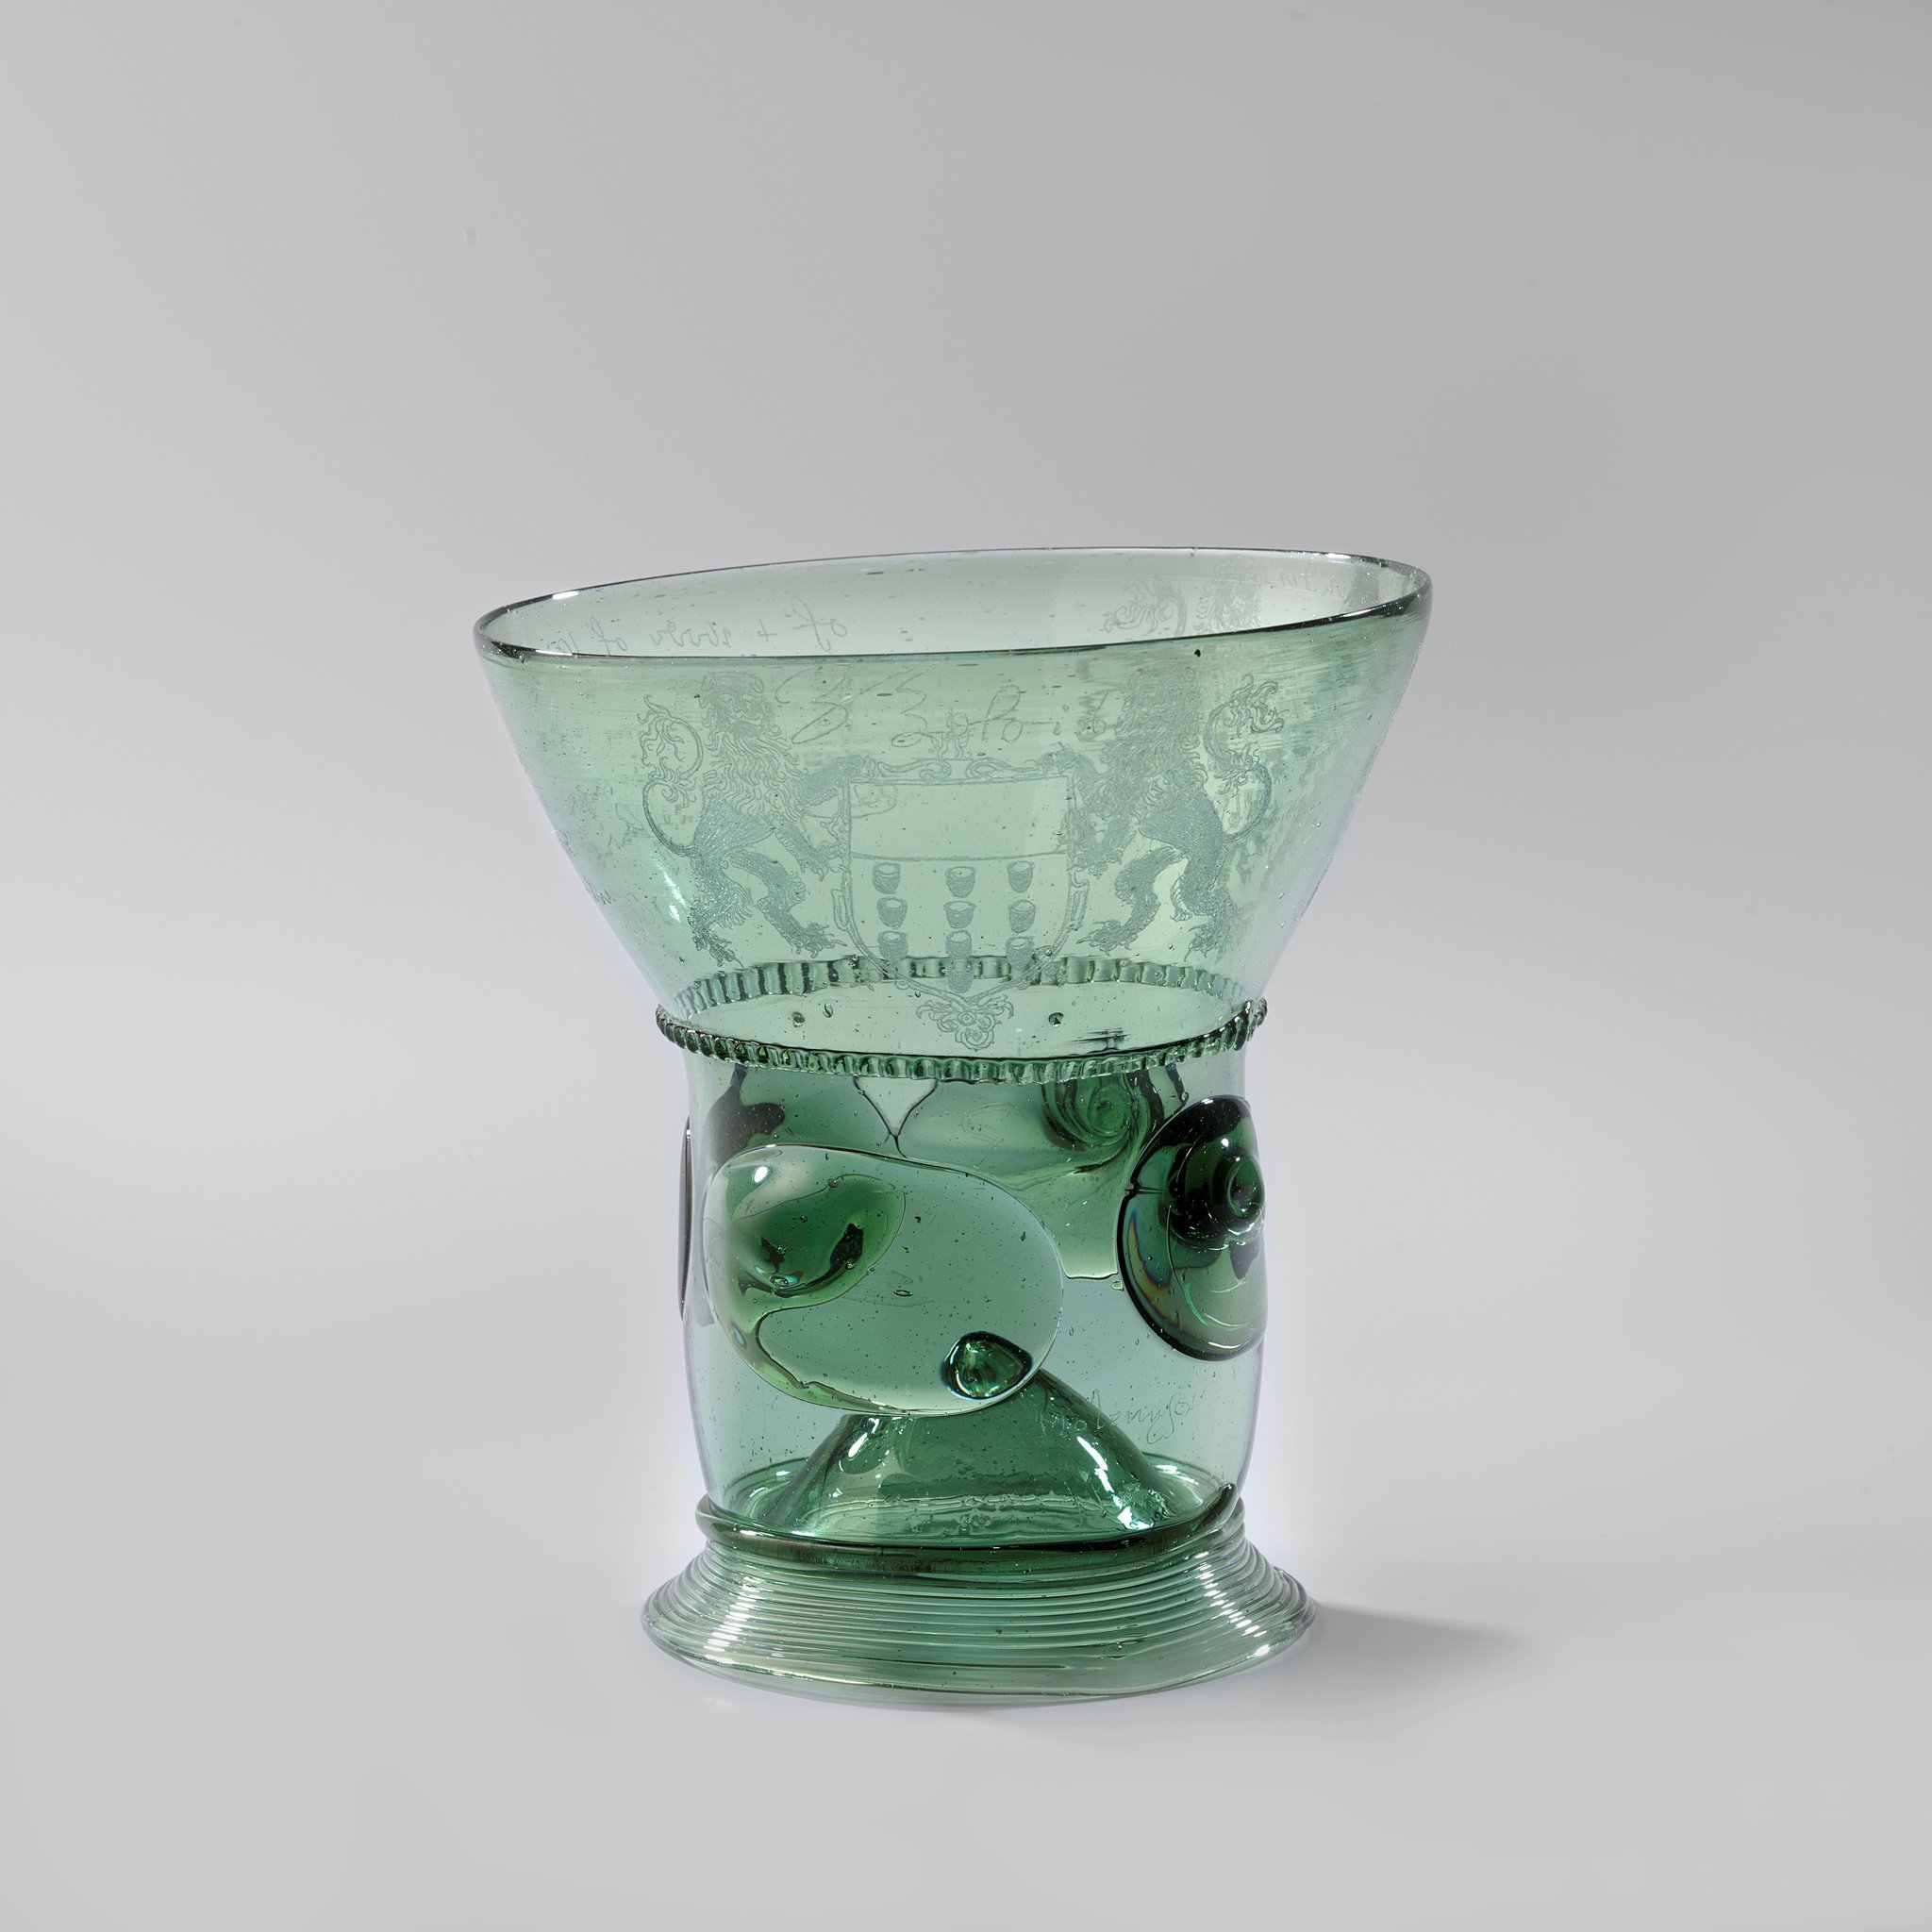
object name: berkenmeier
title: Berkenmeier met de wapens van de familie Blois en stad Schoonhoven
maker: willem mooleyser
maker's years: 1640-1700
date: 1663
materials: glass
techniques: diamond point engraving, glassblowing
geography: rotterdam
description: Lage, gesponnen voet, diep ingestoken bodem. De rechte, van boven open stam, die bezet is met vier grote platte noppen, is als één geheel geblazen met de trechtervormige kelk. Op de kelk is het wapen van de familie Blois op de ene en dat van de stad Schoonhoven op de andere gegraveerd, alsmeede de volgende teksten: Onder de tekst de datum 'ANNO 1663'. Op de stam de signatuur 'Molenyser' en op de andere kant 'M'.